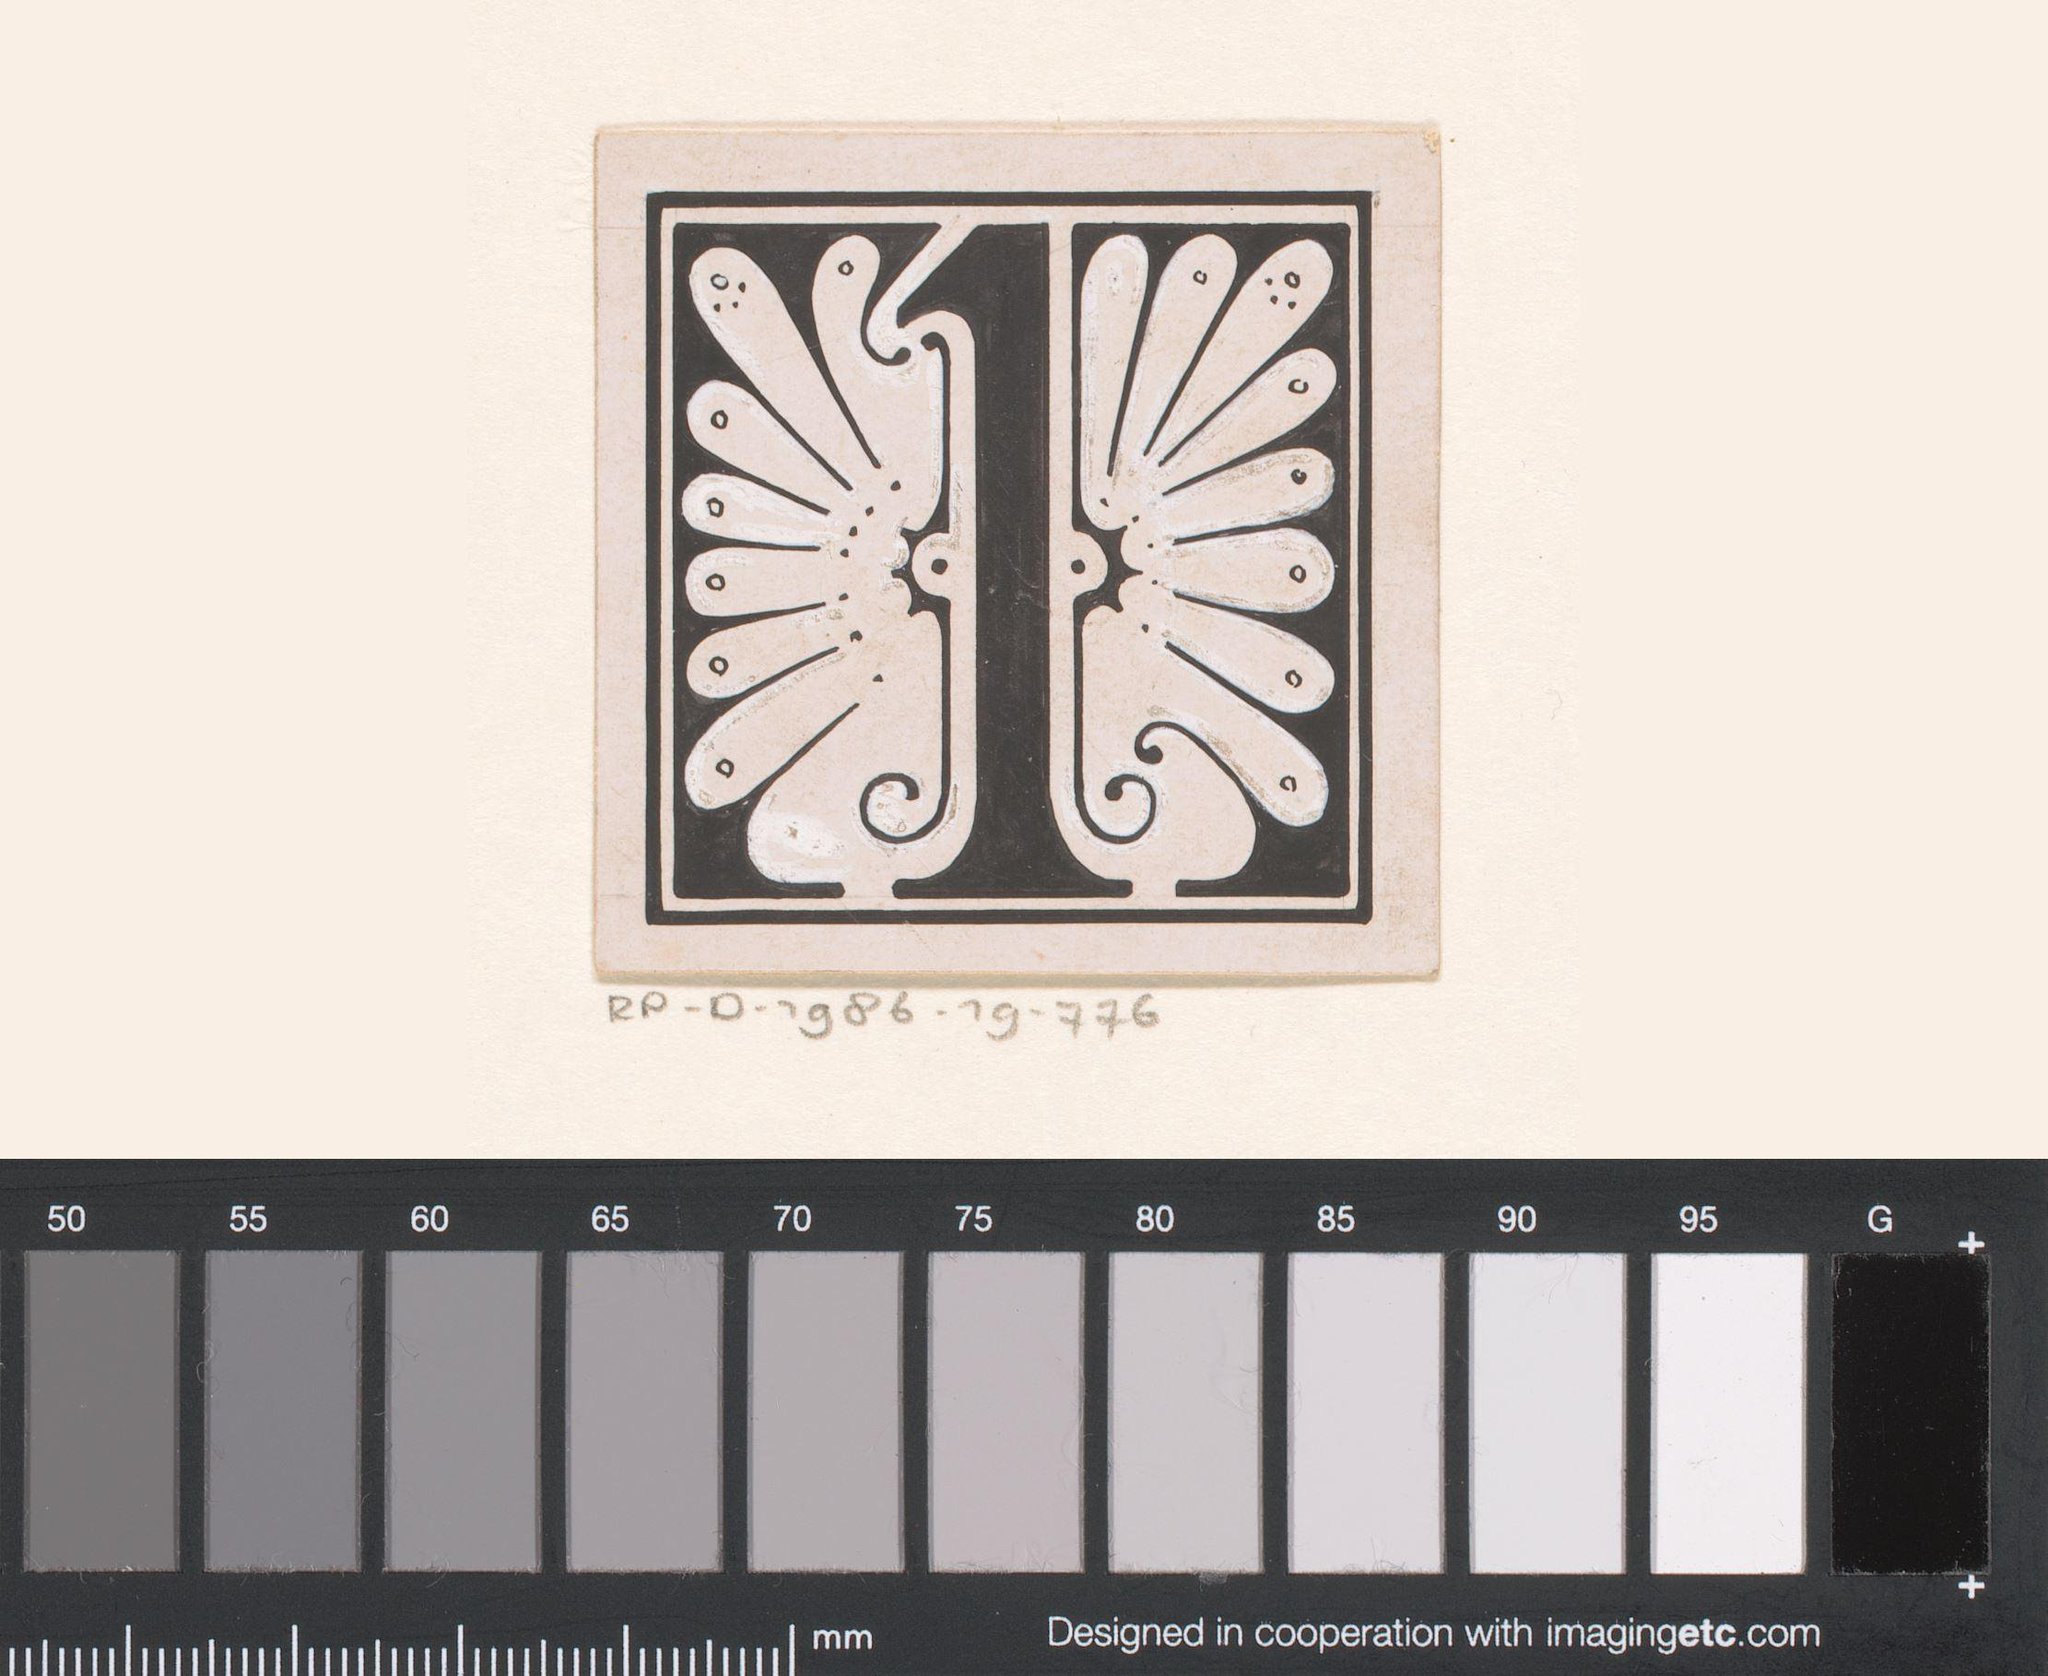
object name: drawing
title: Getal 1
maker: reinier willem petrus de vries (1874-1953)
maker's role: draughtsman, print maker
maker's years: 1874-1953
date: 1904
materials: paint, ink, paper, pencil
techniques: brush, pen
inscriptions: collector's mark: ‘R:MVS.’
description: Het getal is gebruikt voor: Veth, Jan. Jozef Israëls en zijn kunst. Arnhem en Nijmegen: Gebroeders E&M Cohen, 1904.